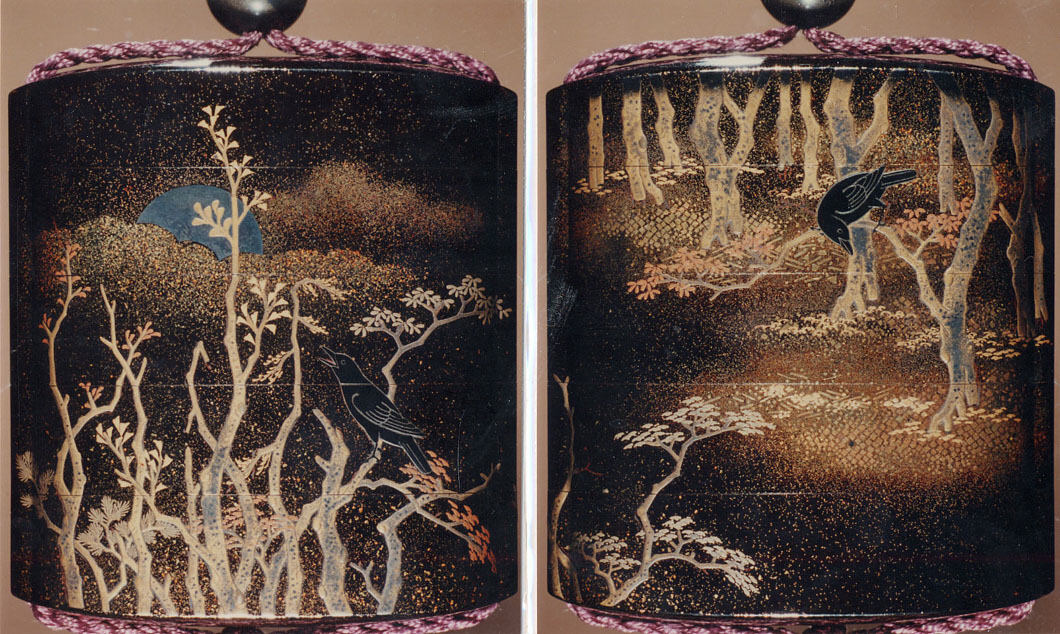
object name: inrō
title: Case (Inrō) with Design of Trees, Crow, and Moon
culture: japanese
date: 1701-1800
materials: foil, gold, lacquer, metal, silver, wood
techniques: fundame, inlay, maki-e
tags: birds,moon,trees